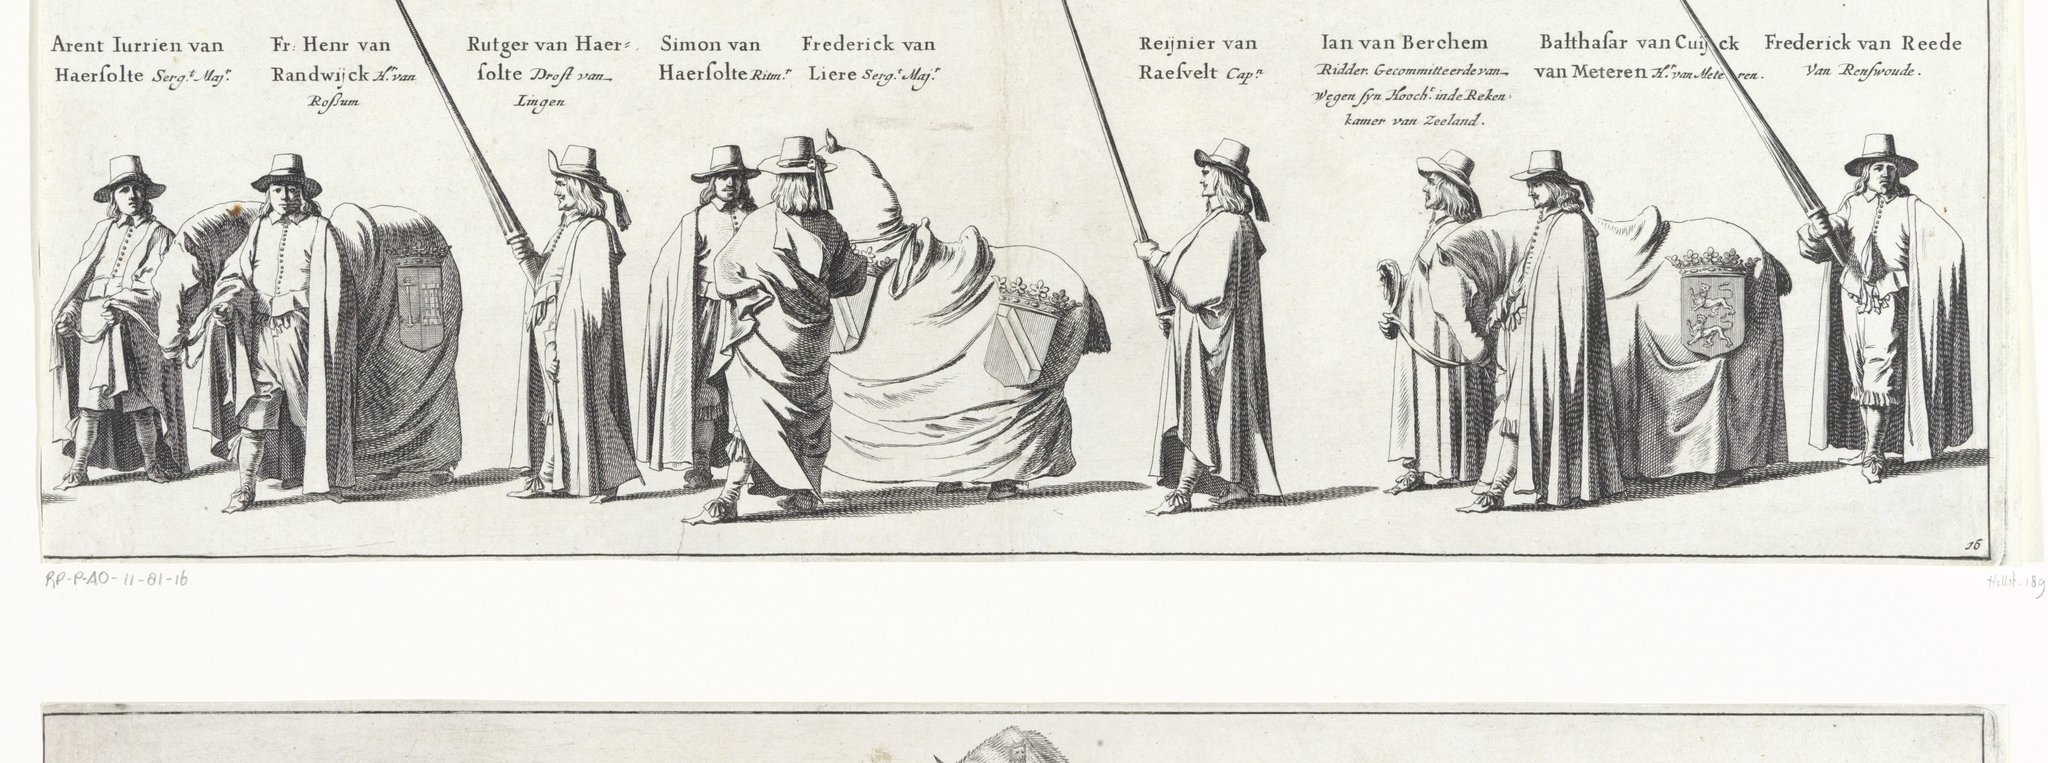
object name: print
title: De begrafenisstoet van stadhouder Frederik Hendrik te 's-Gravenhage in 1647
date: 1651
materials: paper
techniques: engraving, etching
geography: the hague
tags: cortege, funeral procession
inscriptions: collector's mark: Lugt 2228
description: De begrafenisstoet van stadhouder Frederik Hendrik te 's-Gravenhage op 10 mei 1647. Plaat nr. 16 met een deel van de stoet met vaandeldragers en twee paarden, boven de personen staan hun naam en functie. Onderdeel van een serie van 30 platen en 20 tekstbladen, bedoeld om aan elkaar geplakt te worden.